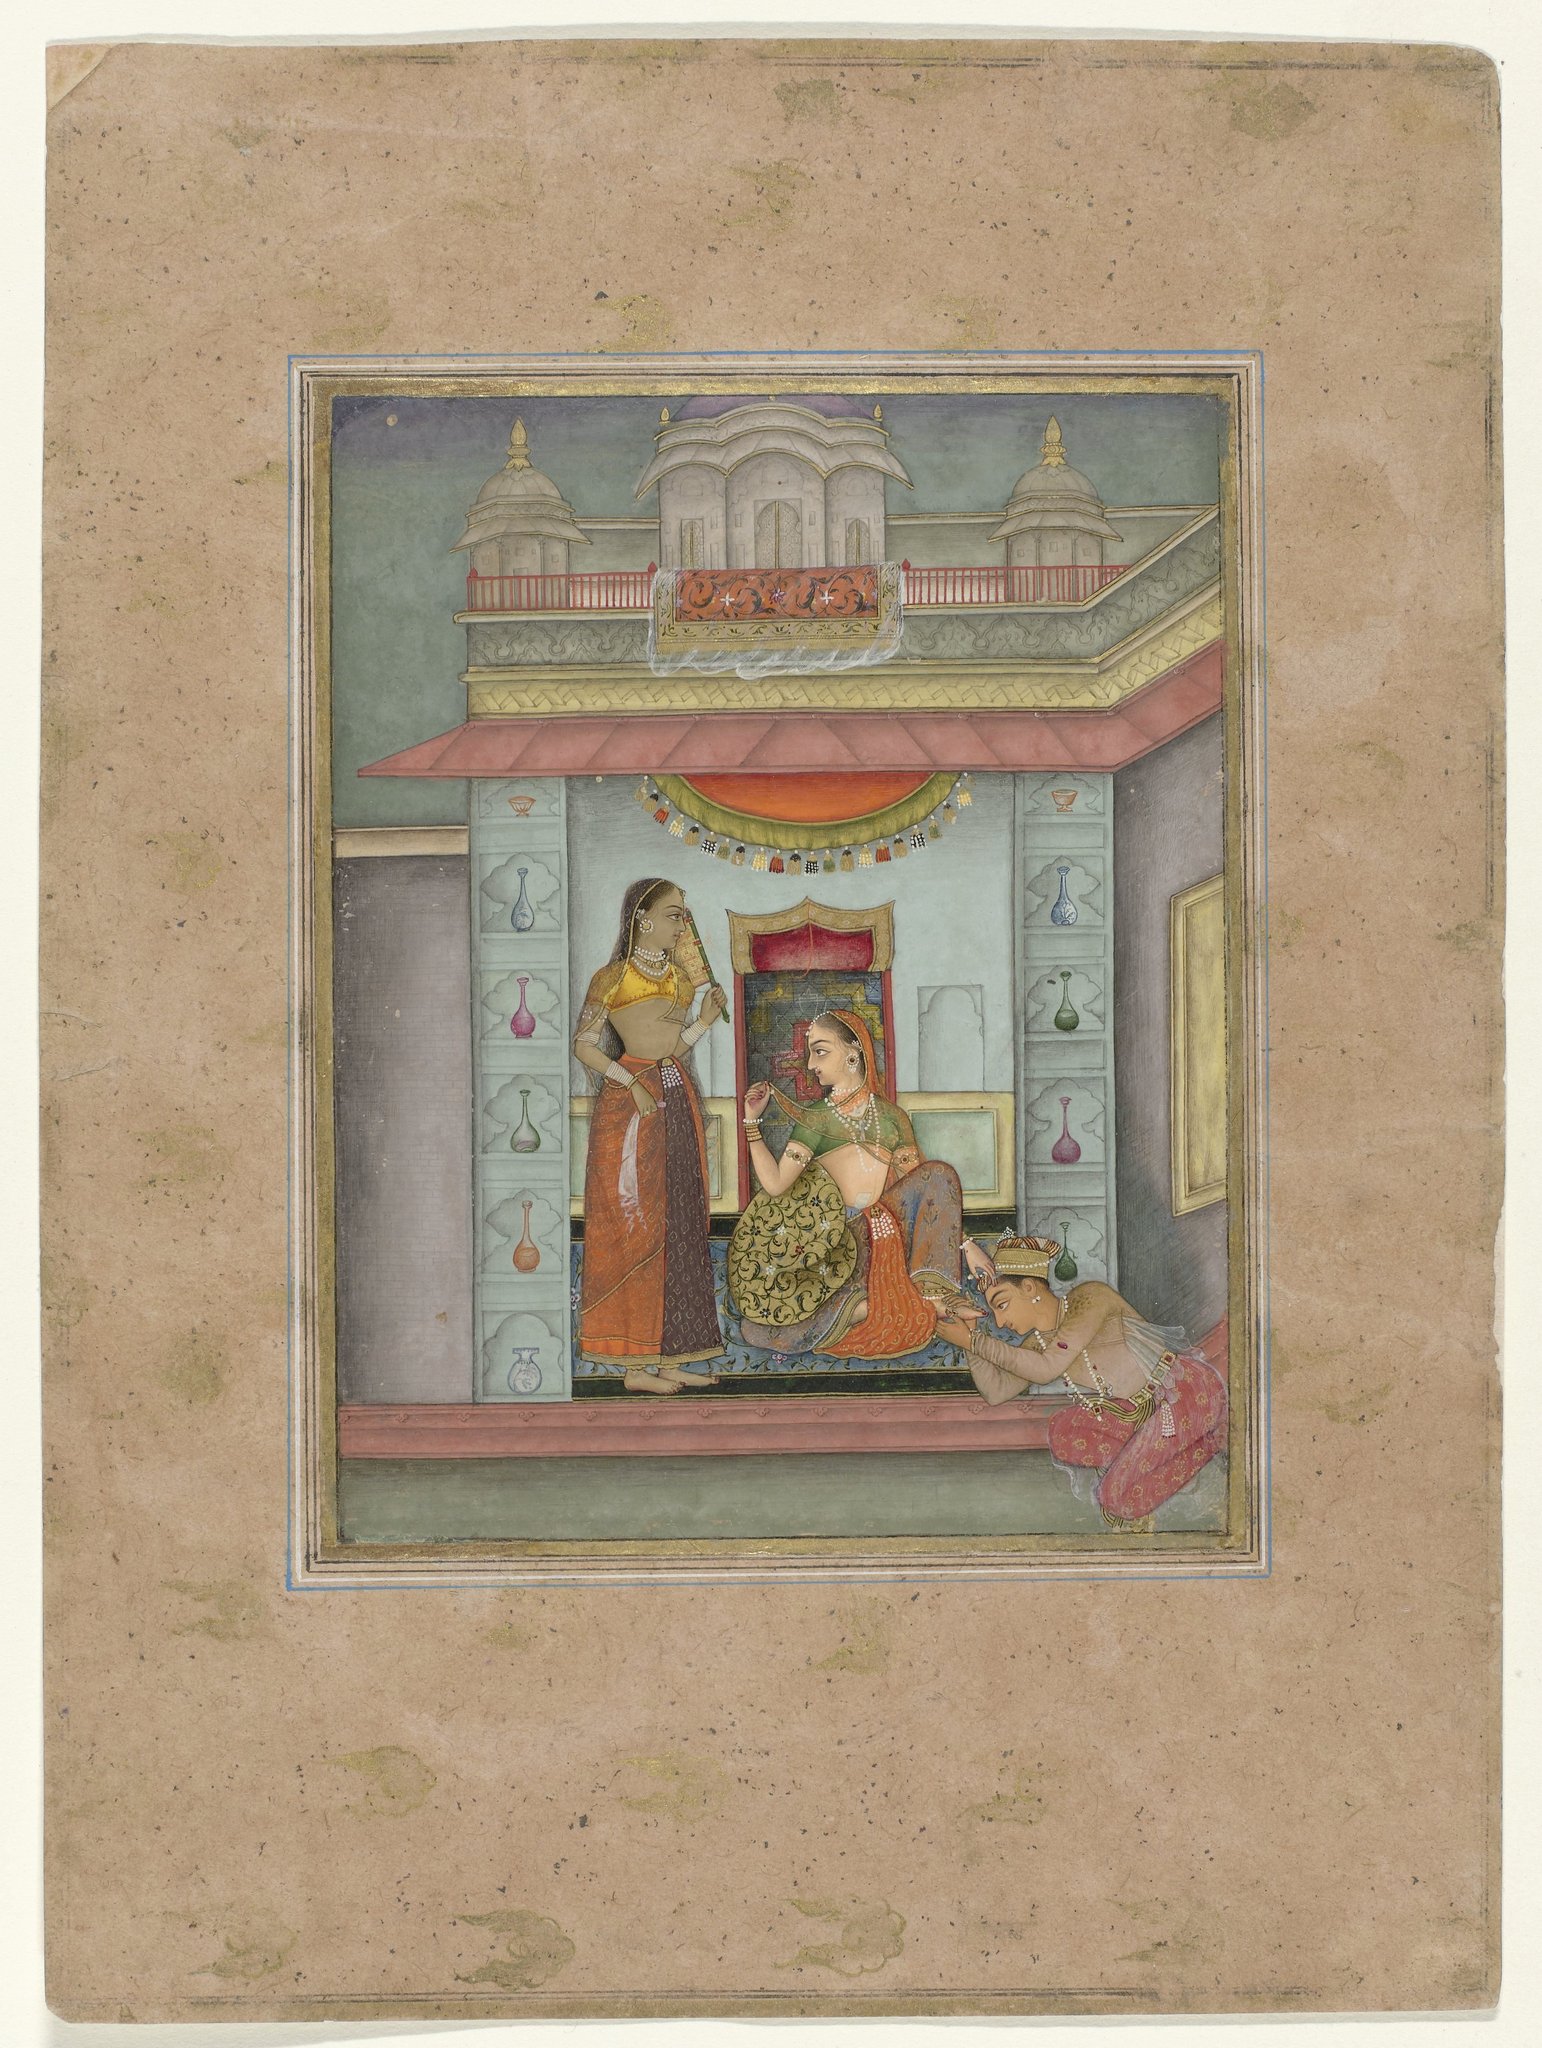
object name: indian miniature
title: Ramakali-ragini, een prinses met twee dienaren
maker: Anonymous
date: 1675-1700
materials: paint, paper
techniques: brush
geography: bikaner